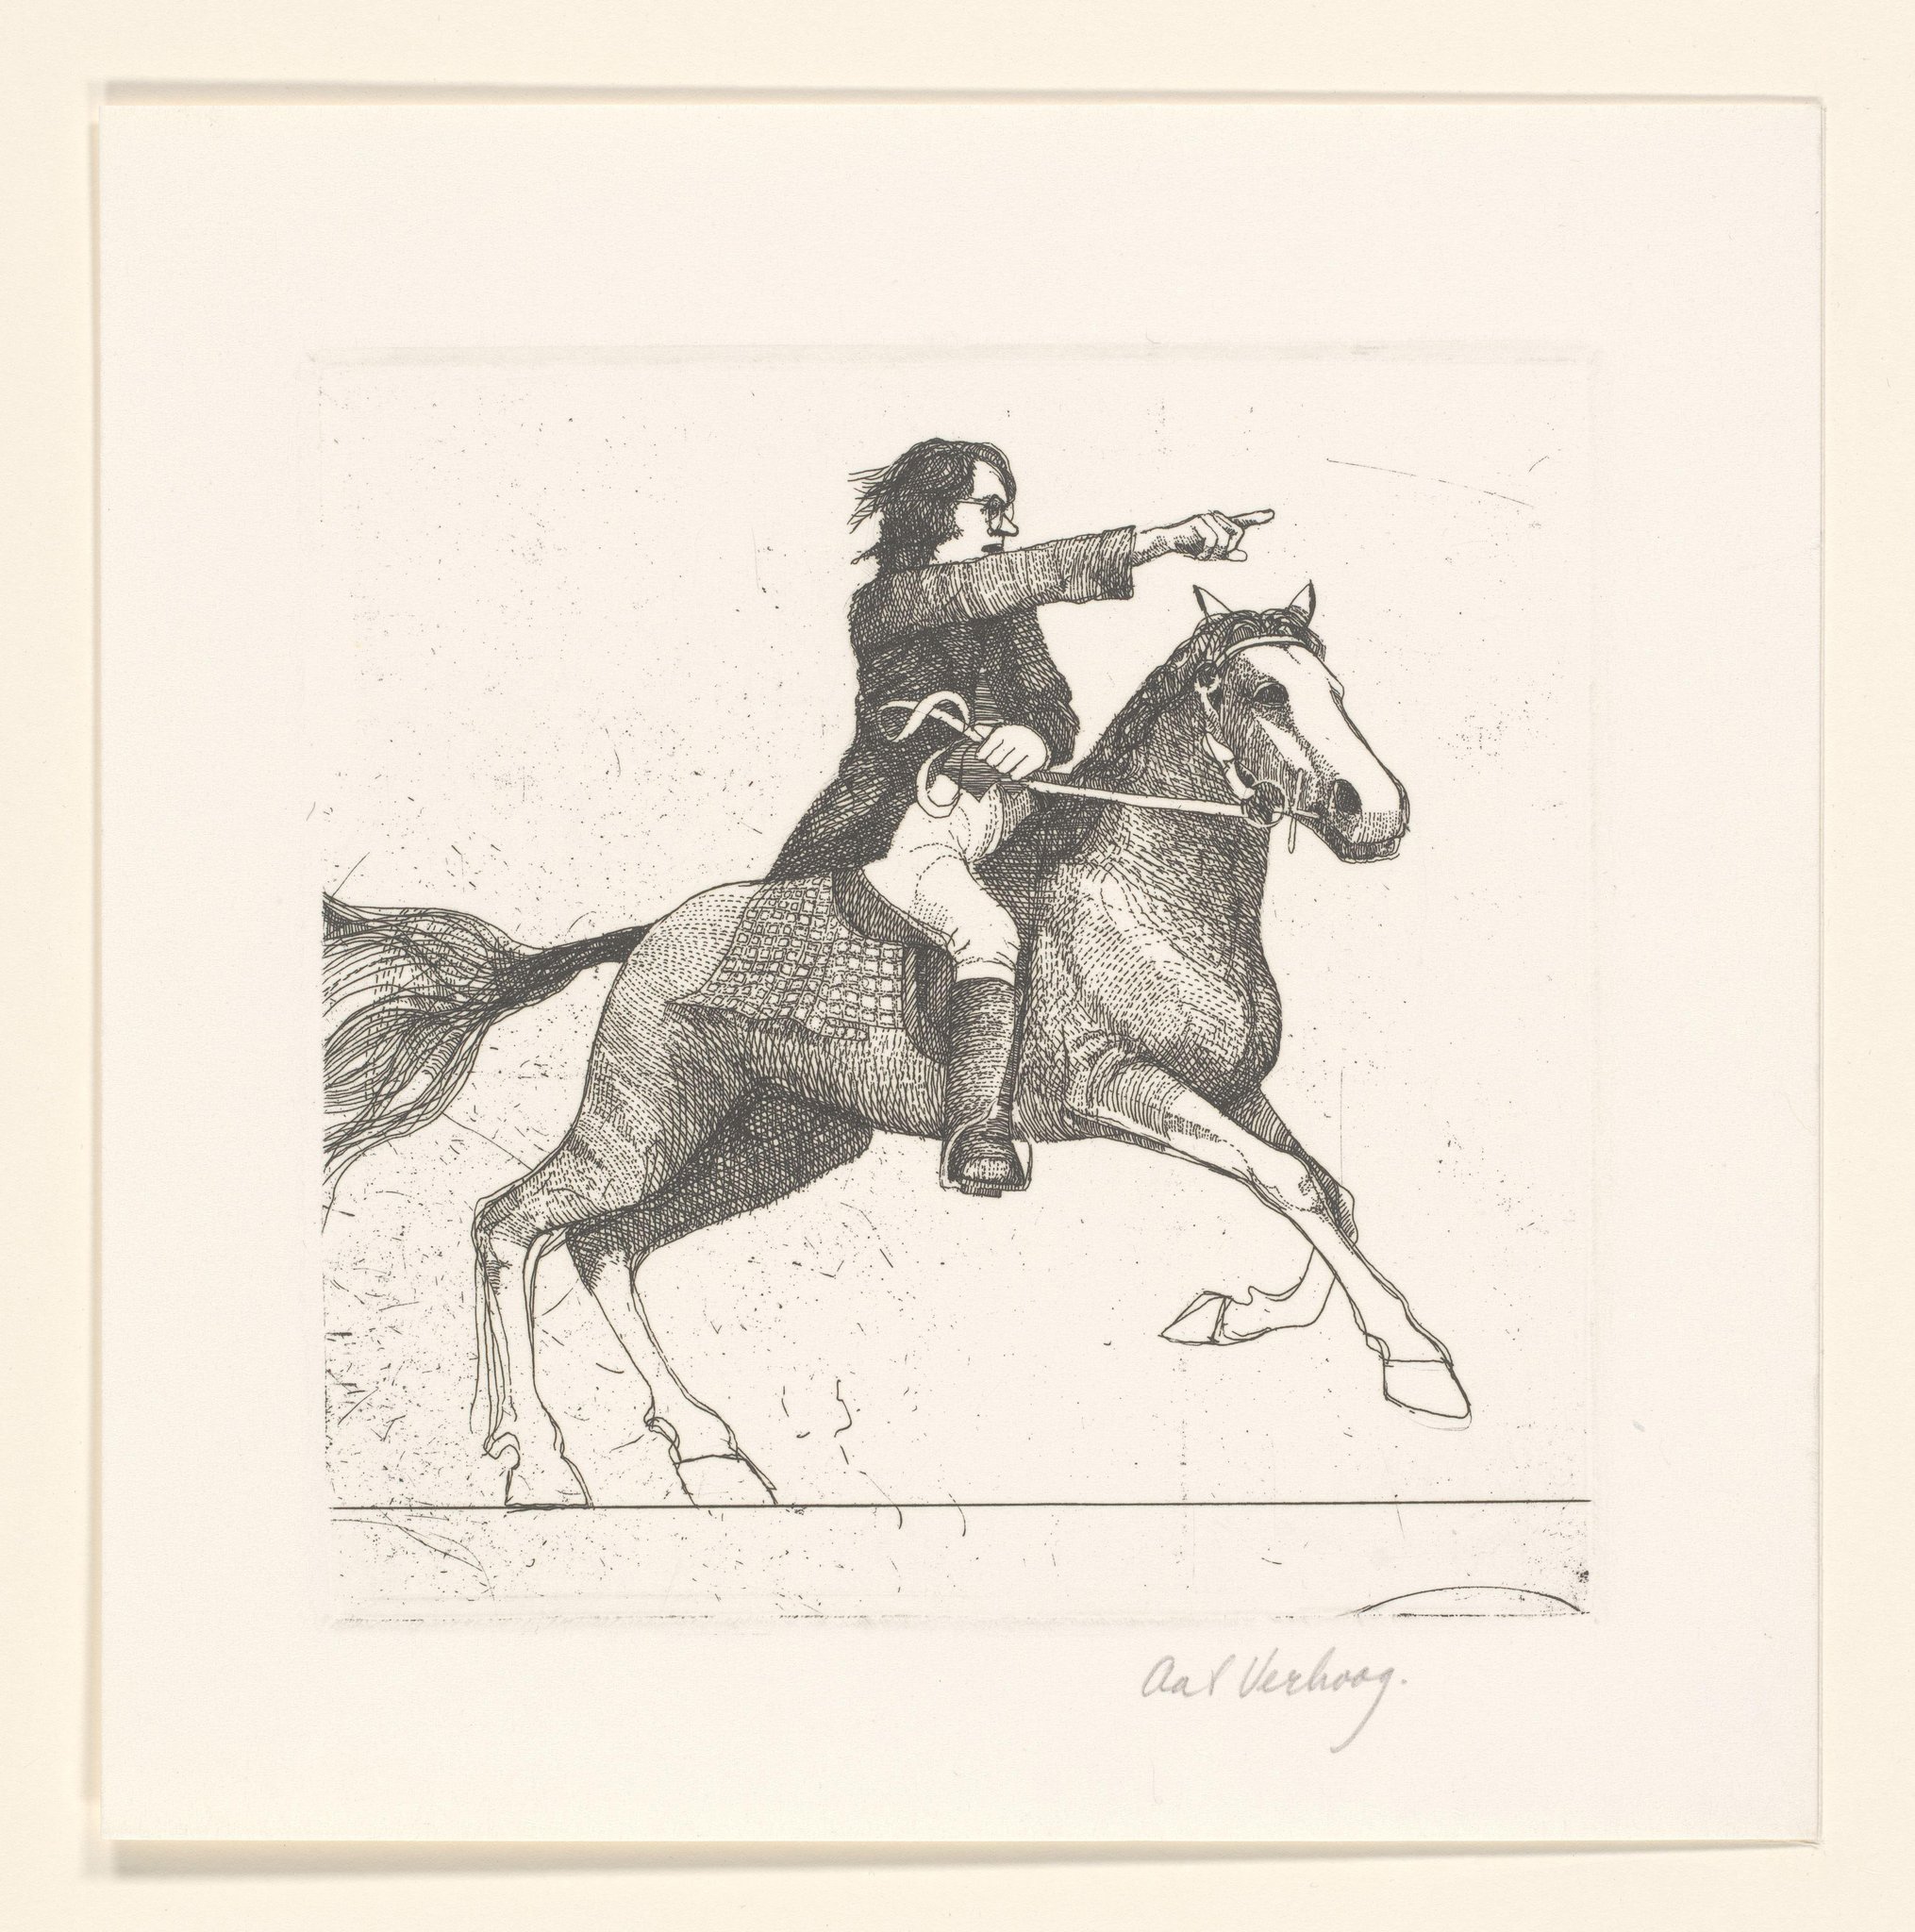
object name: print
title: Wijzende man op galloperend paard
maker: aat verhoog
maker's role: print maker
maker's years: 1933-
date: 1965-1980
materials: paper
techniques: etching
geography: netherlands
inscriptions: signature: ‘Aat Verhoog’